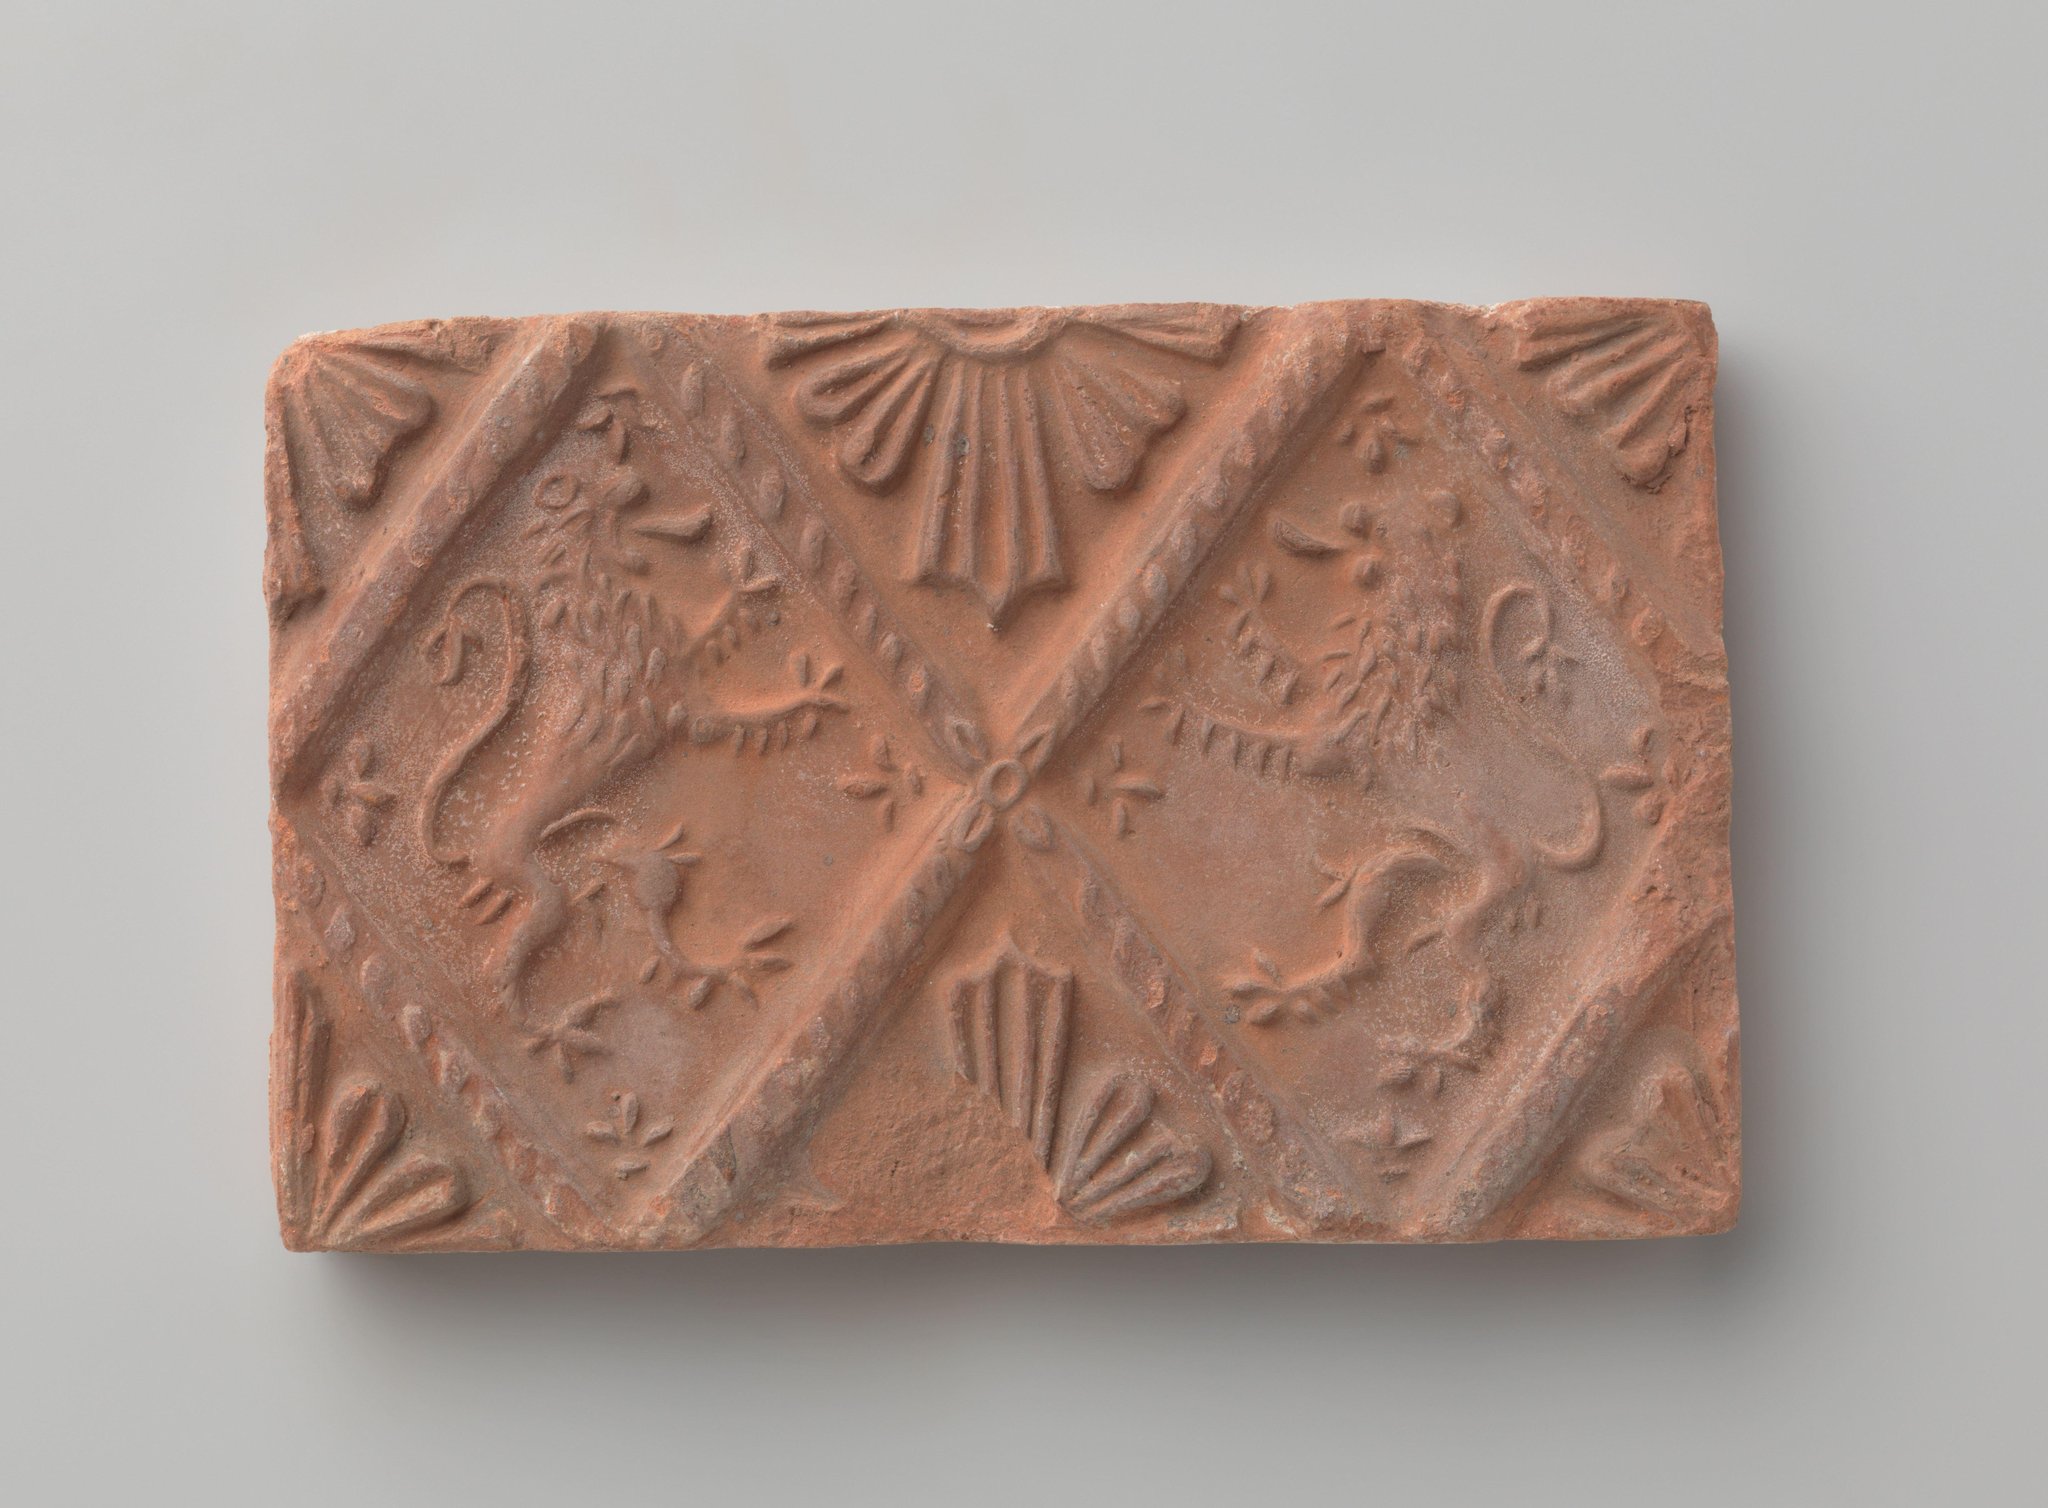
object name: hearthstone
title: Haardsteen met voorstelling van twee klimmende leeuwen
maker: Anonymous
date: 1875-1900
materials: earthenware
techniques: printing, firing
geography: netherlands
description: Haardsteen met voorstelling van twee klimmende leeuwen, geplaatst in geprofileerde ruit. De halve ruiten aan de boven- en onderkant zijn opgevuld met stermotief.